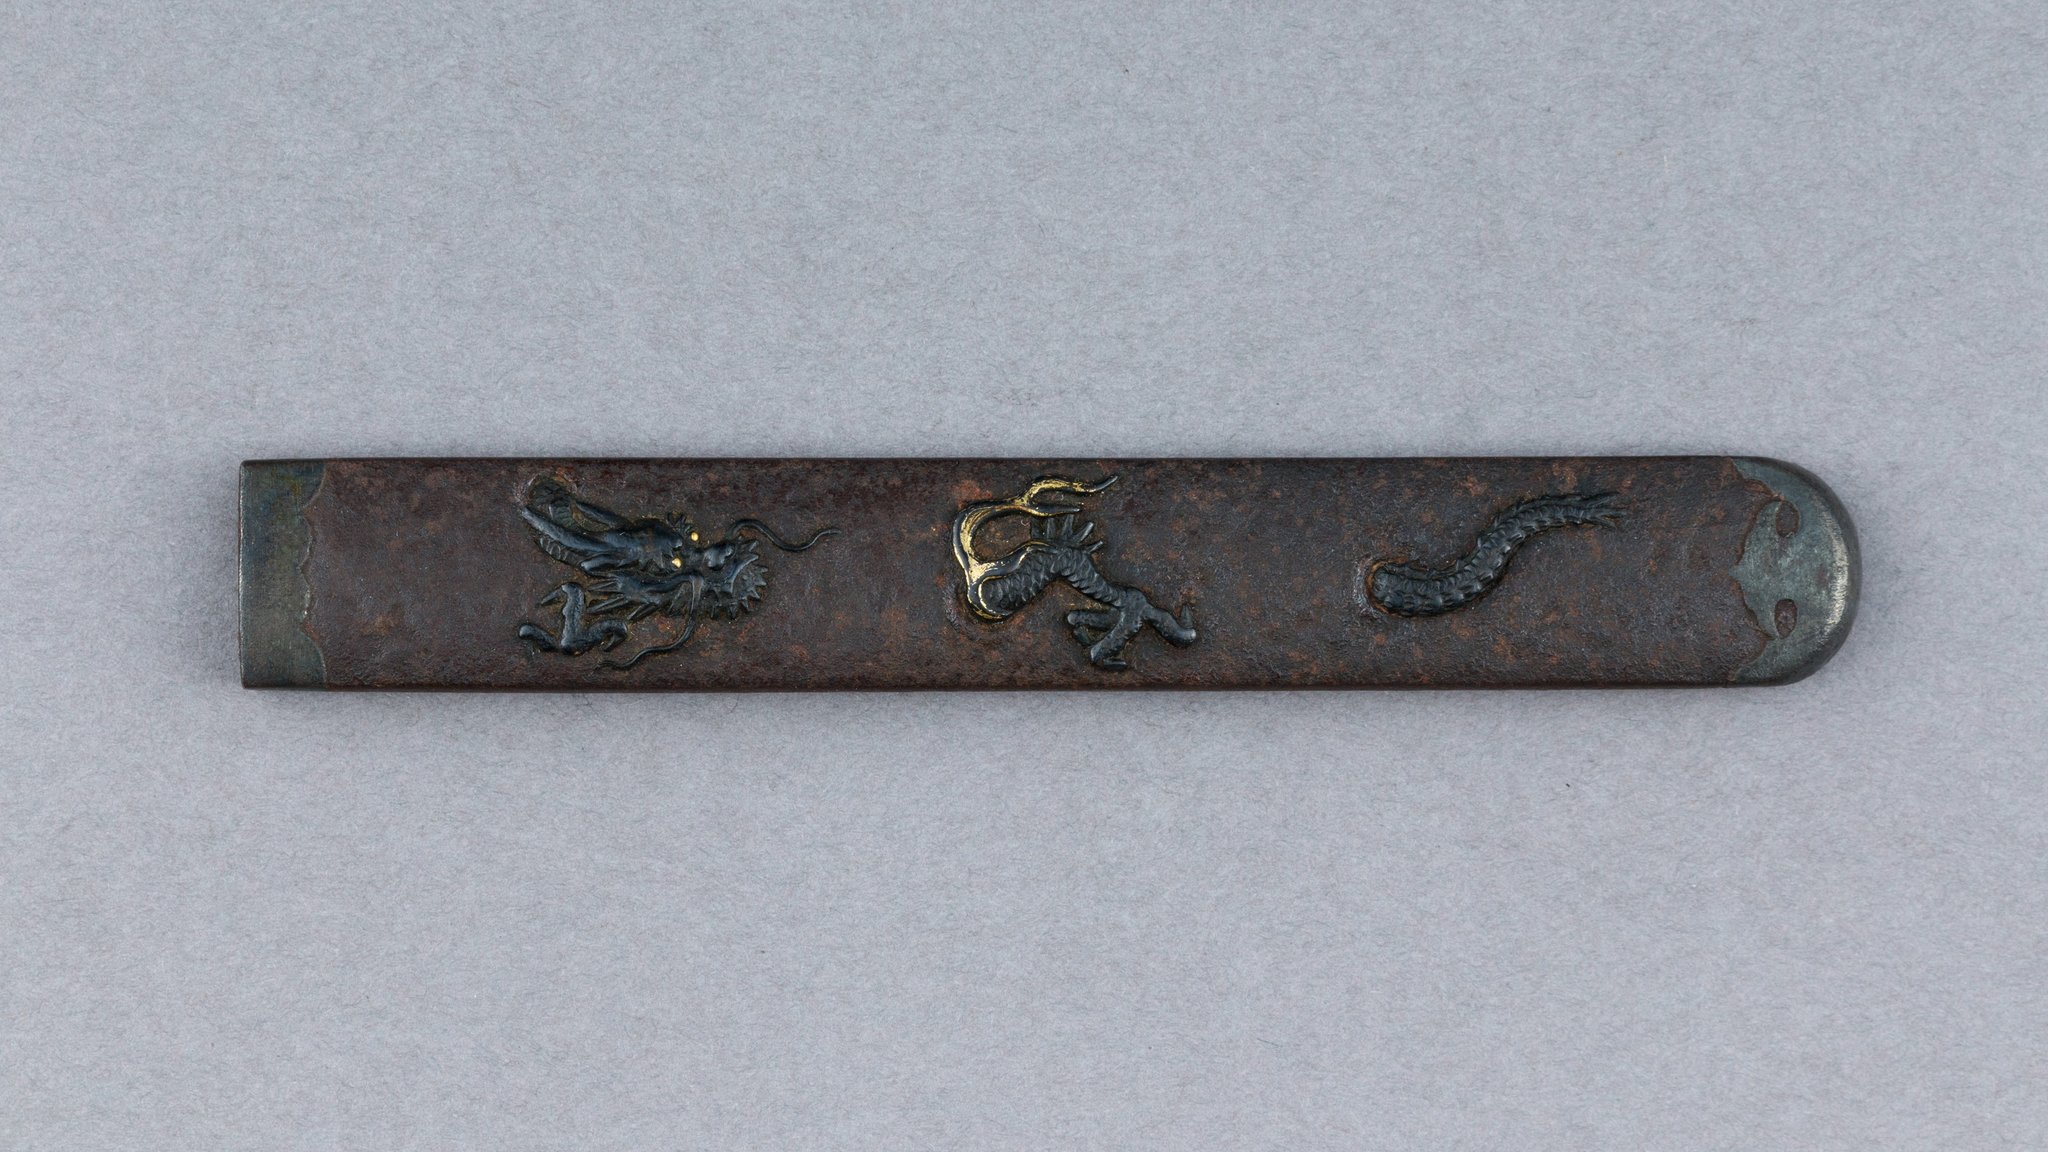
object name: knife handle kozuka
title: Knife Handle (Kozuka)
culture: japanese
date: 1615-1868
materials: gold alloy, iron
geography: japan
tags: dragons